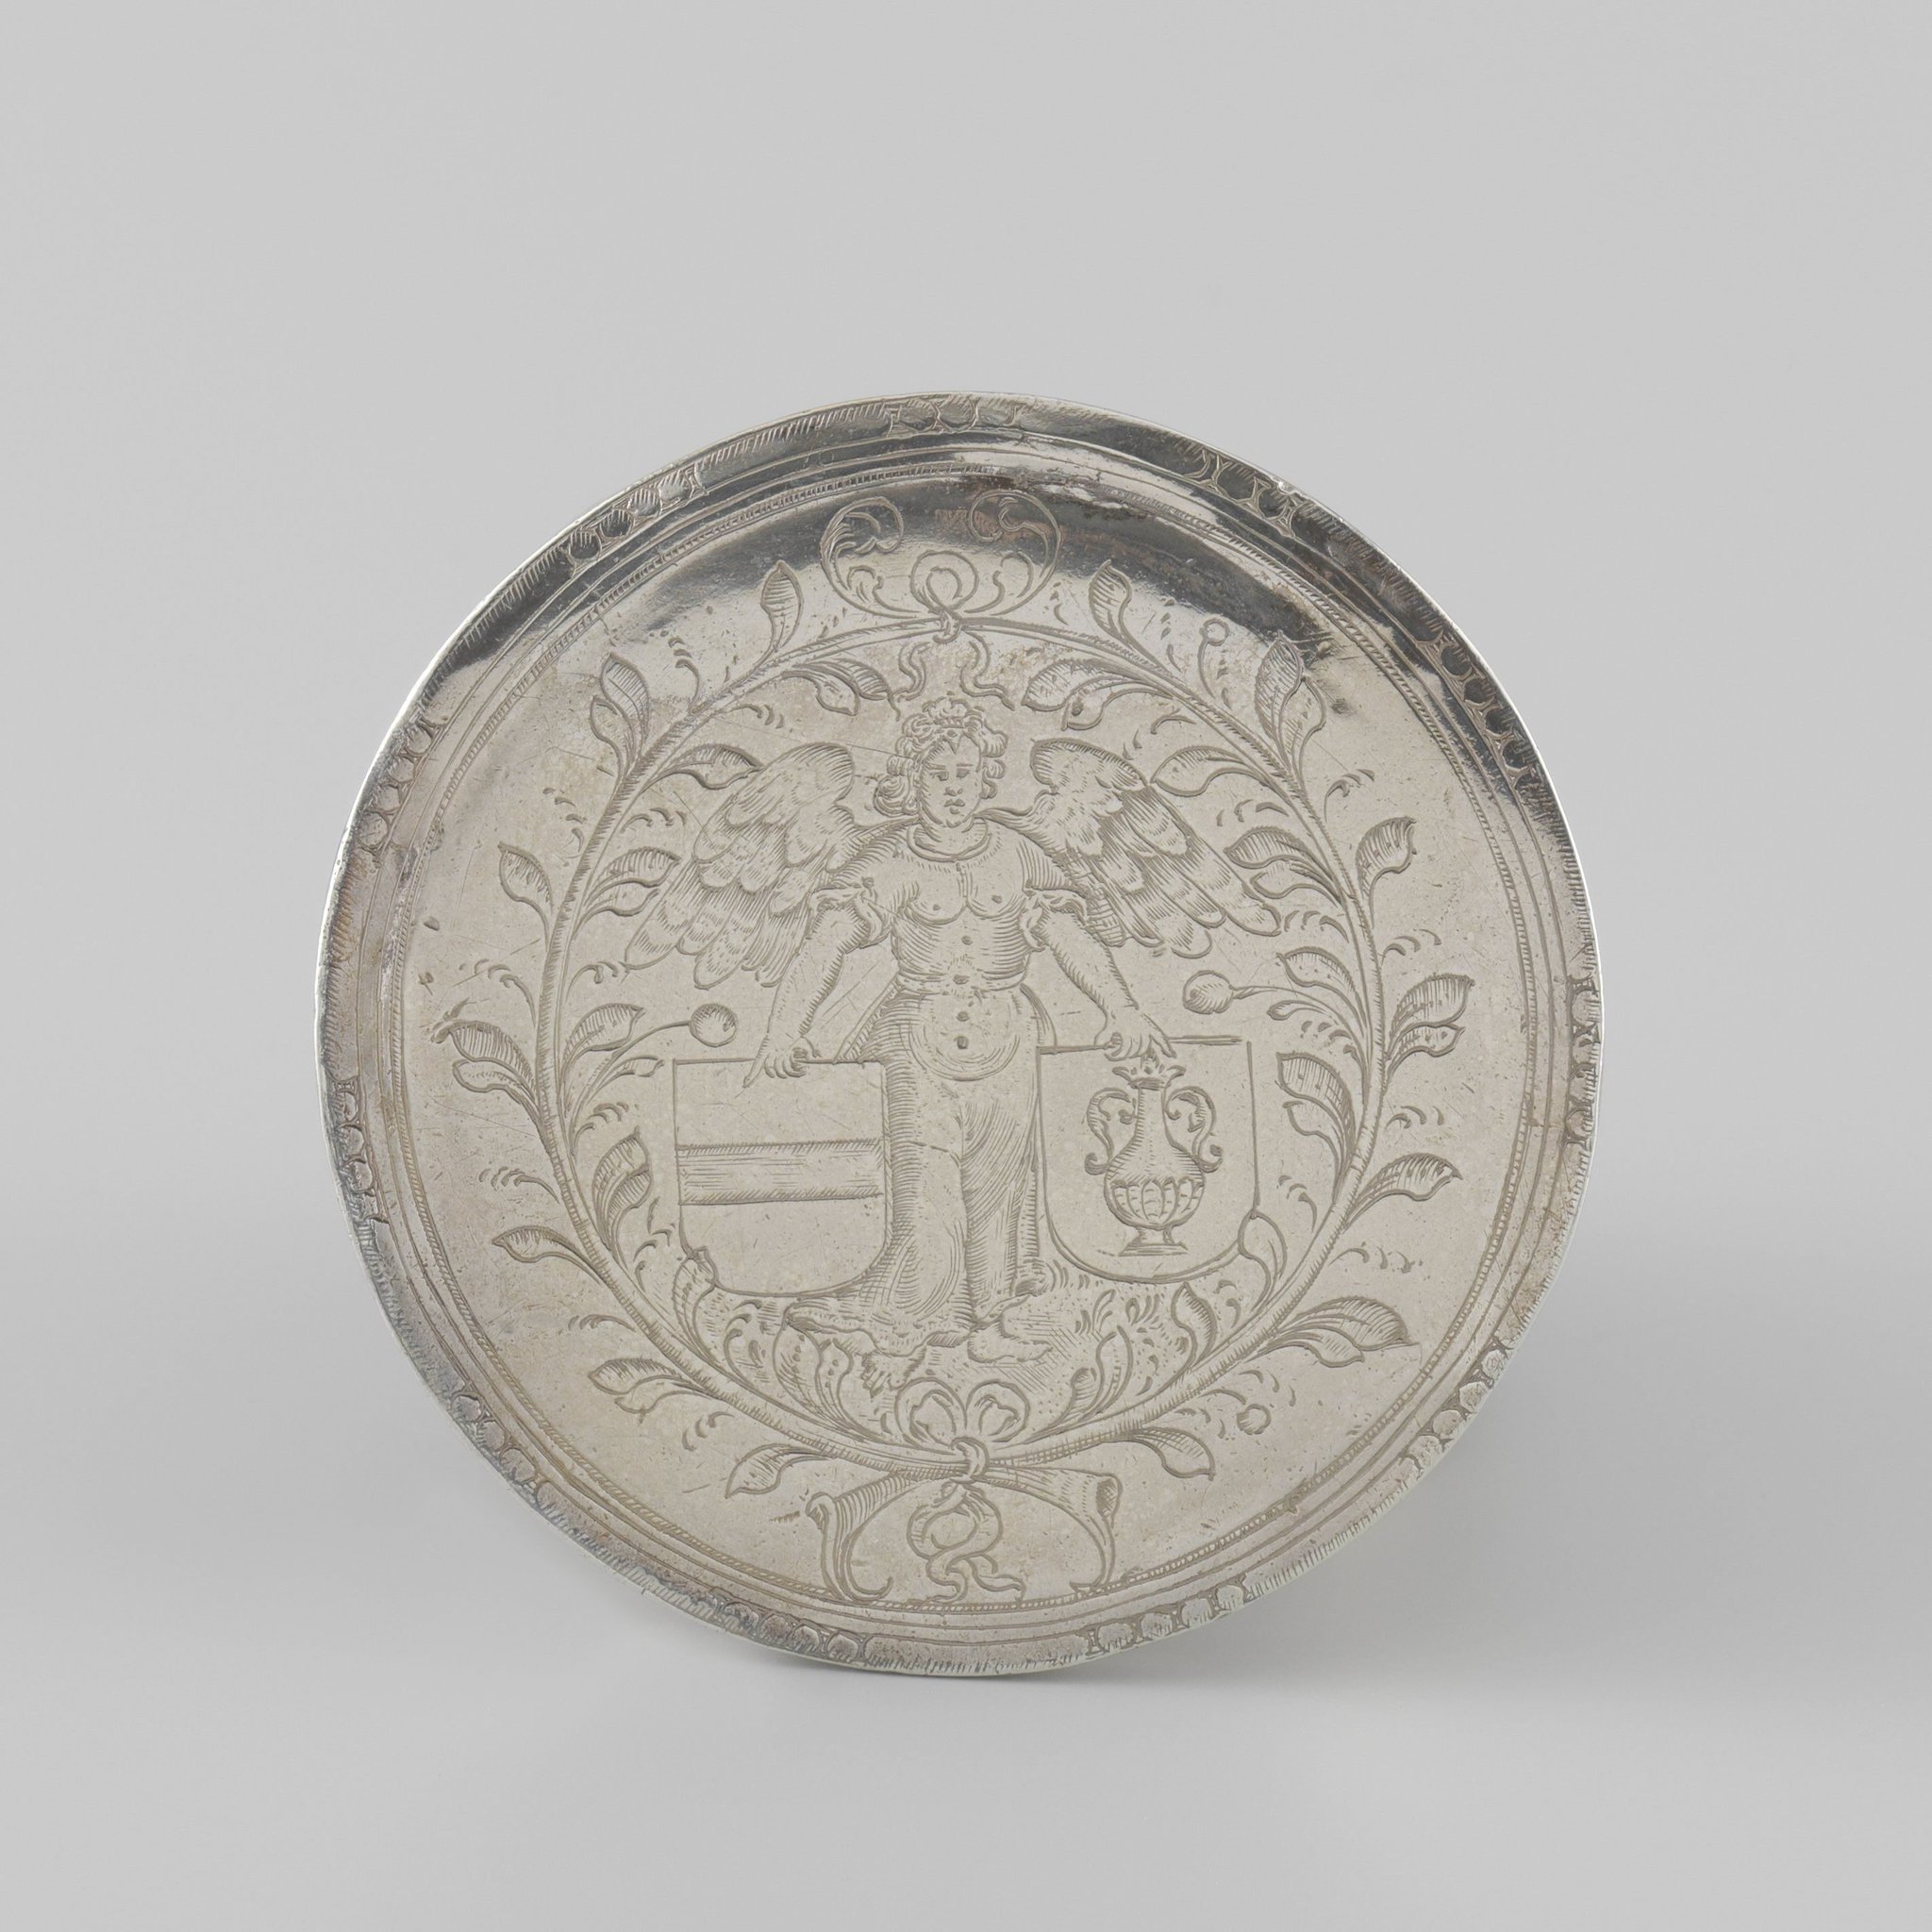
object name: salt condiment vessel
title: Deel van een gecombineerd zoutvat-specerijdoos met deksel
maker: Anonymous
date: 1622-1632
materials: silver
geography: flushing